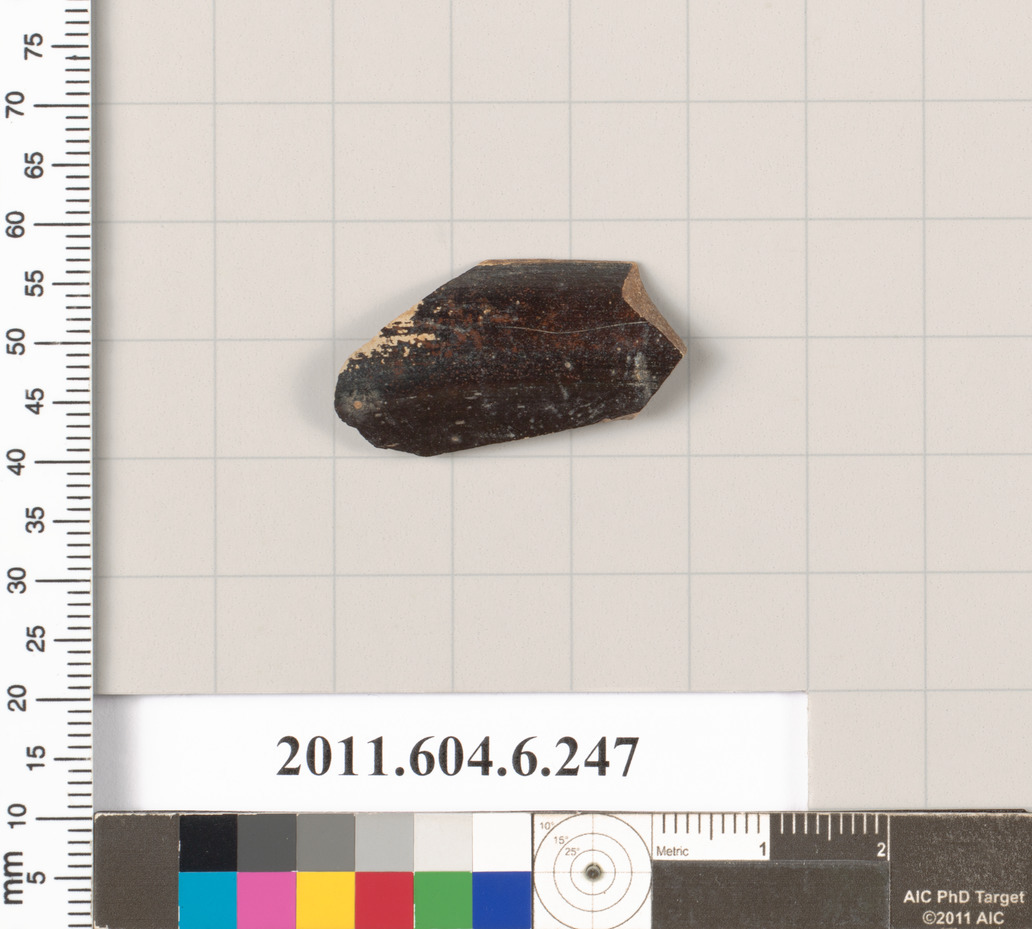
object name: undetermined open shape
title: Terracotta rim fragment of an open shape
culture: greek, attic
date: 600-301 BCE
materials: terracotta